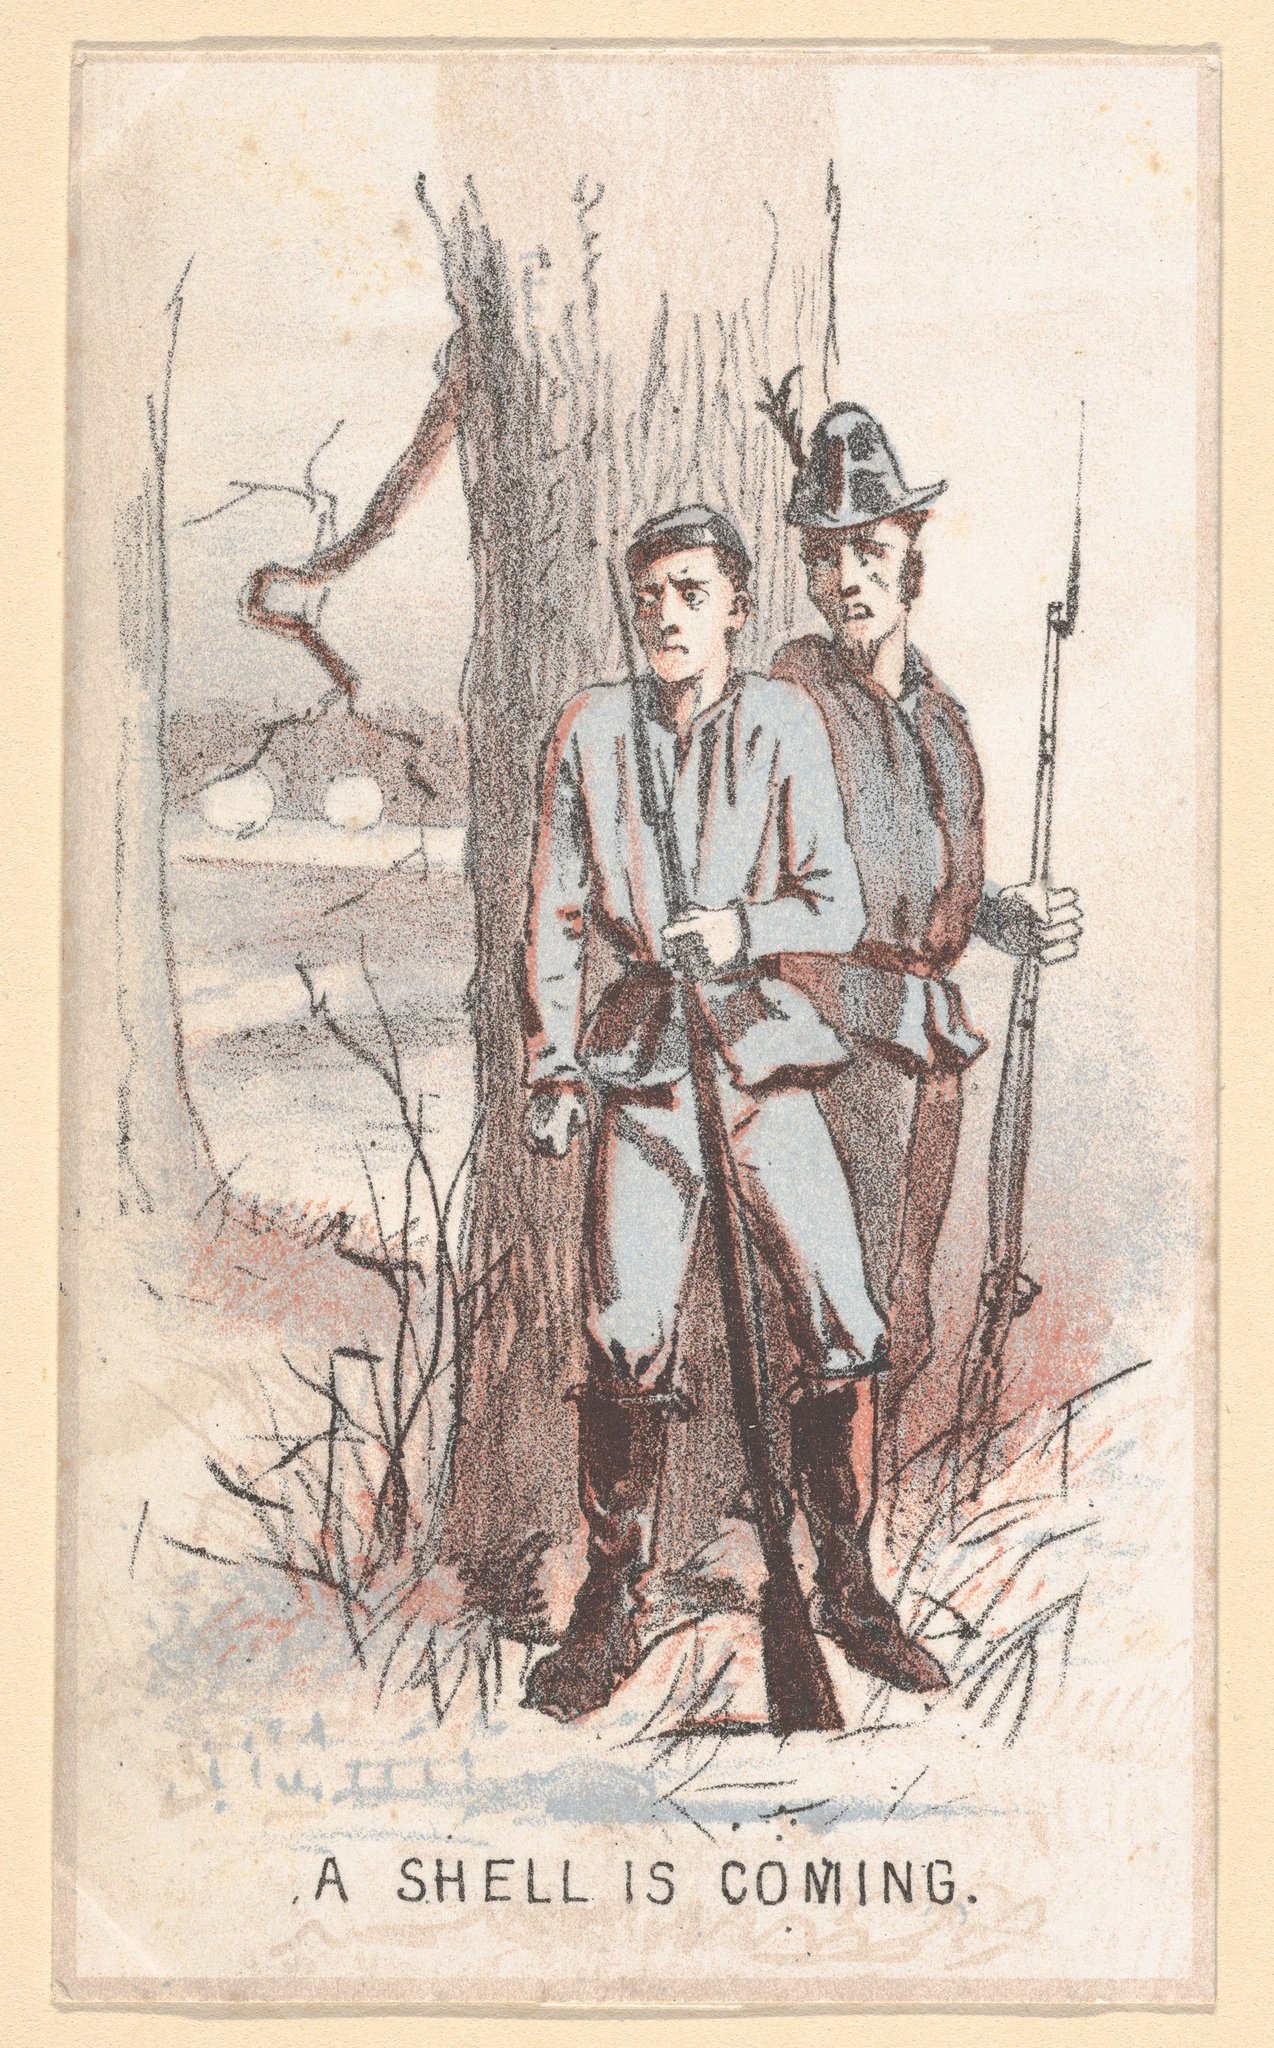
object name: print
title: Life in Camp, Part 1: A Shell is Coming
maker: winslow homer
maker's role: artist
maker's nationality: american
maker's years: 1836-1910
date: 1864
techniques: lithograph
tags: soldiers,firearms,american civil war,men